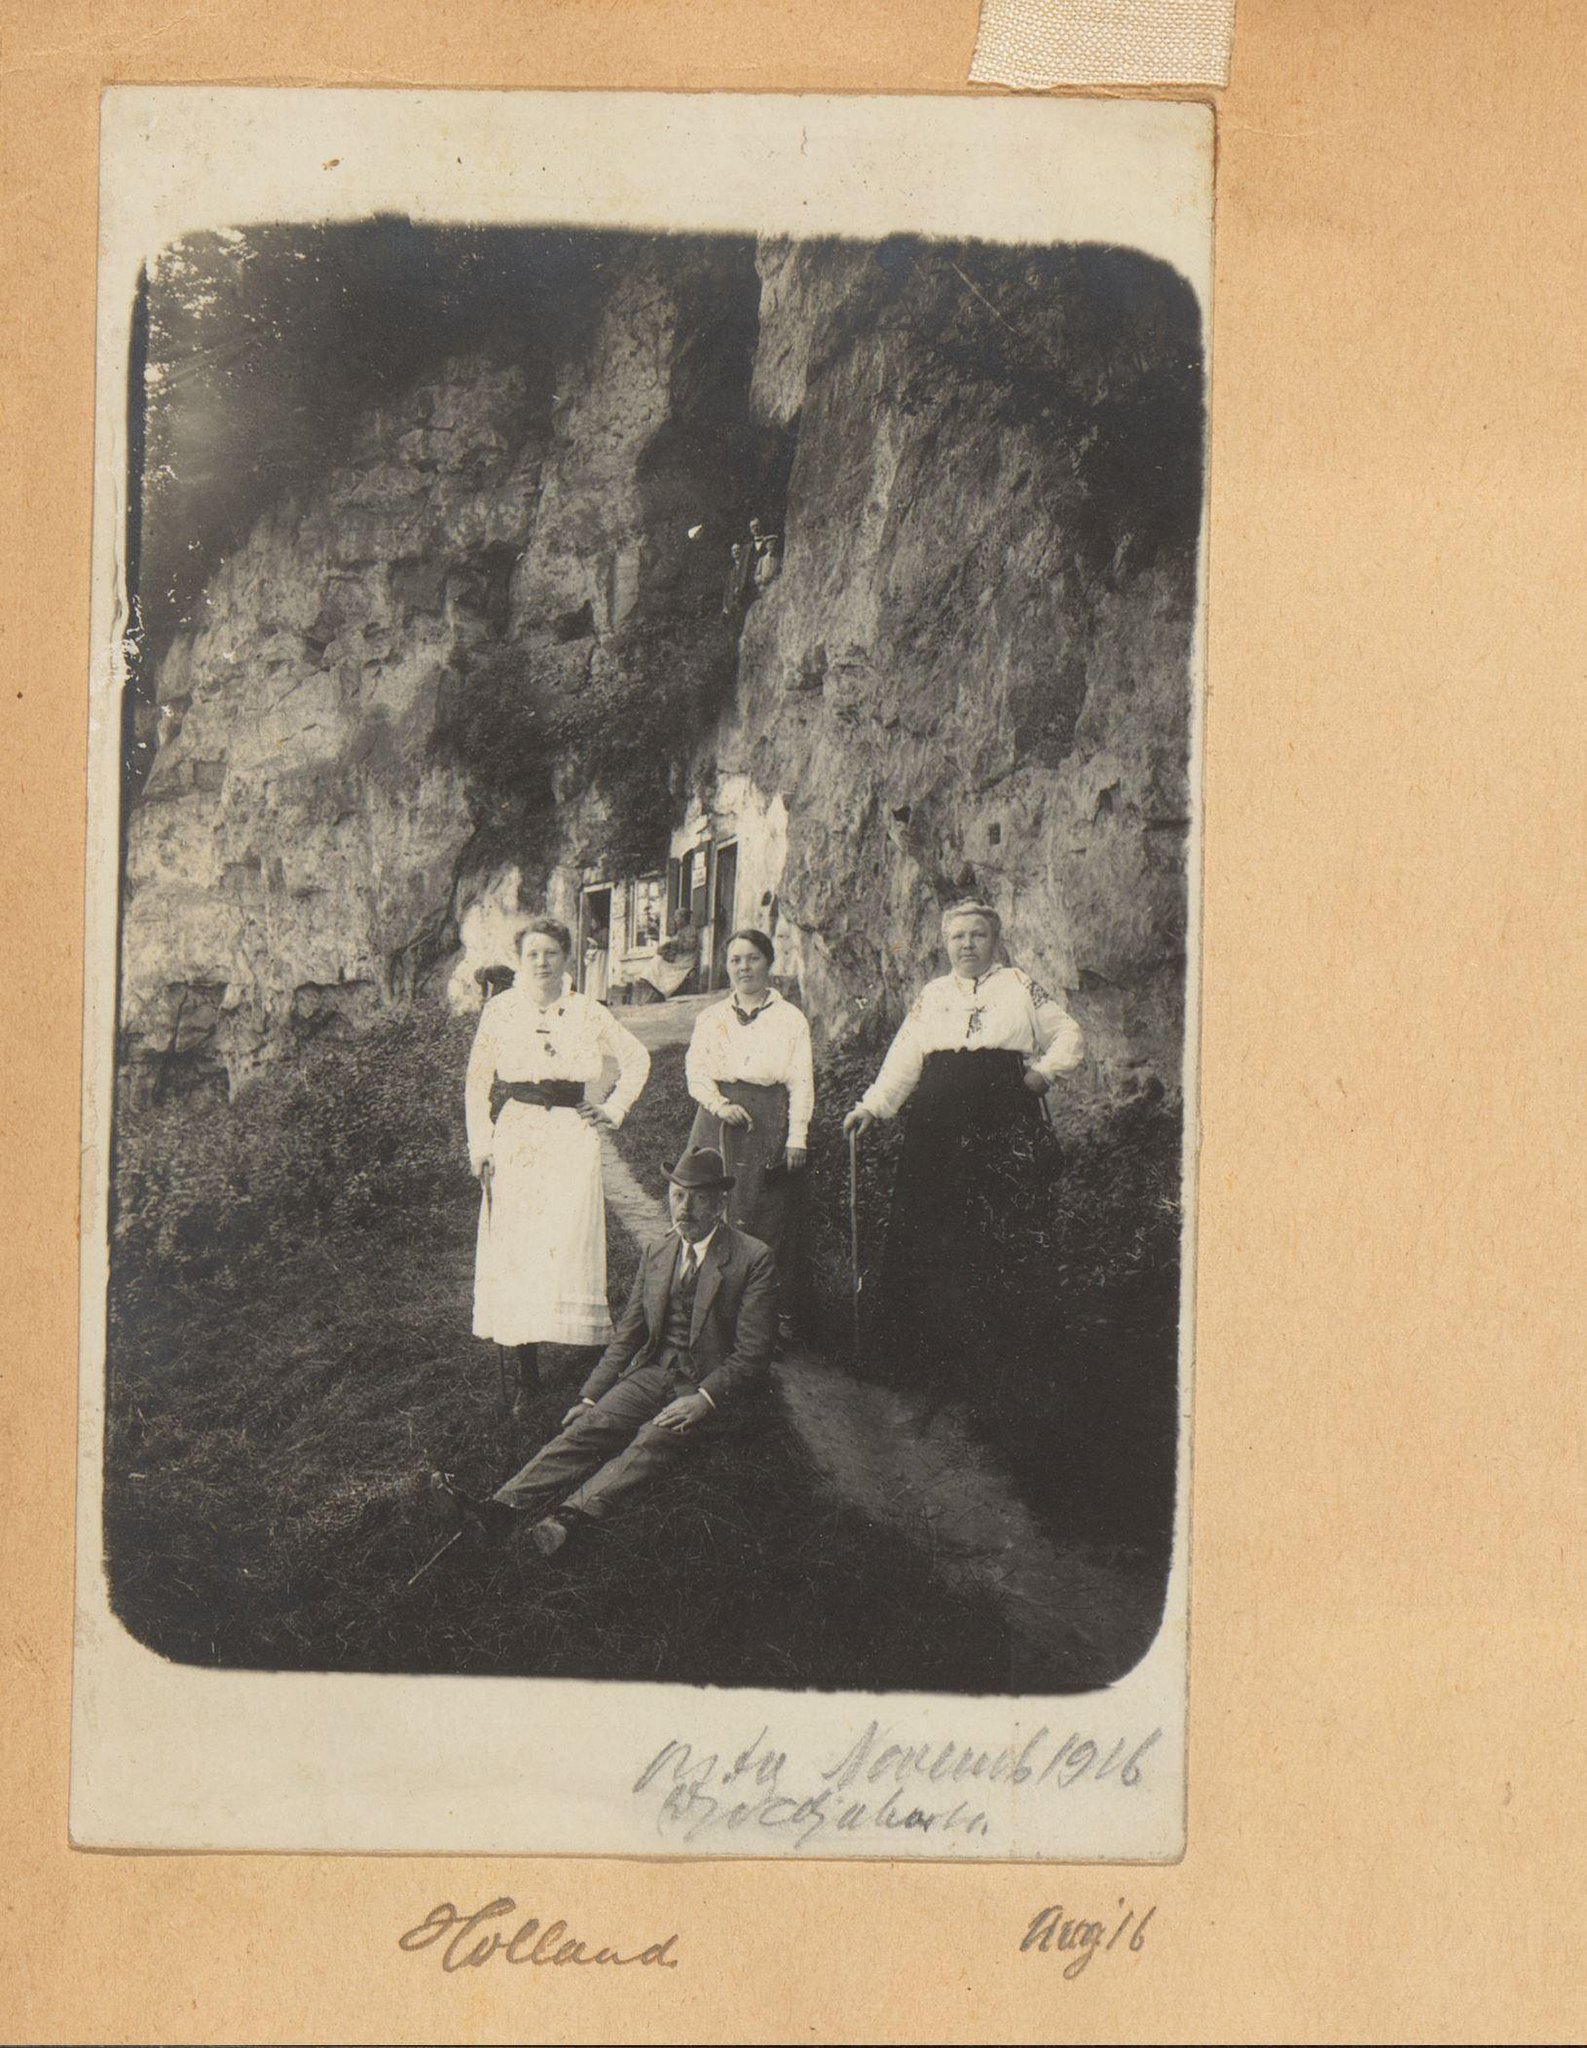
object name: photograph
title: Gezelschap poserend bij rotswoningen, vermoedelijk in Zuid-Nederland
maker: Anonymous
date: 1908-1916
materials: photographic support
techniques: gelatin silver print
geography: netherlands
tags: cave-dwelling, adult woman, adult man, netherlands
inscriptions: inscription: ‘[...] November 1916 Djocjakarta’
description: Onderdeel van Familiealbum met foto's van een familie in de voormalige kolonie Nederlands-Indië en van een suikerfabriek in Purworejo.